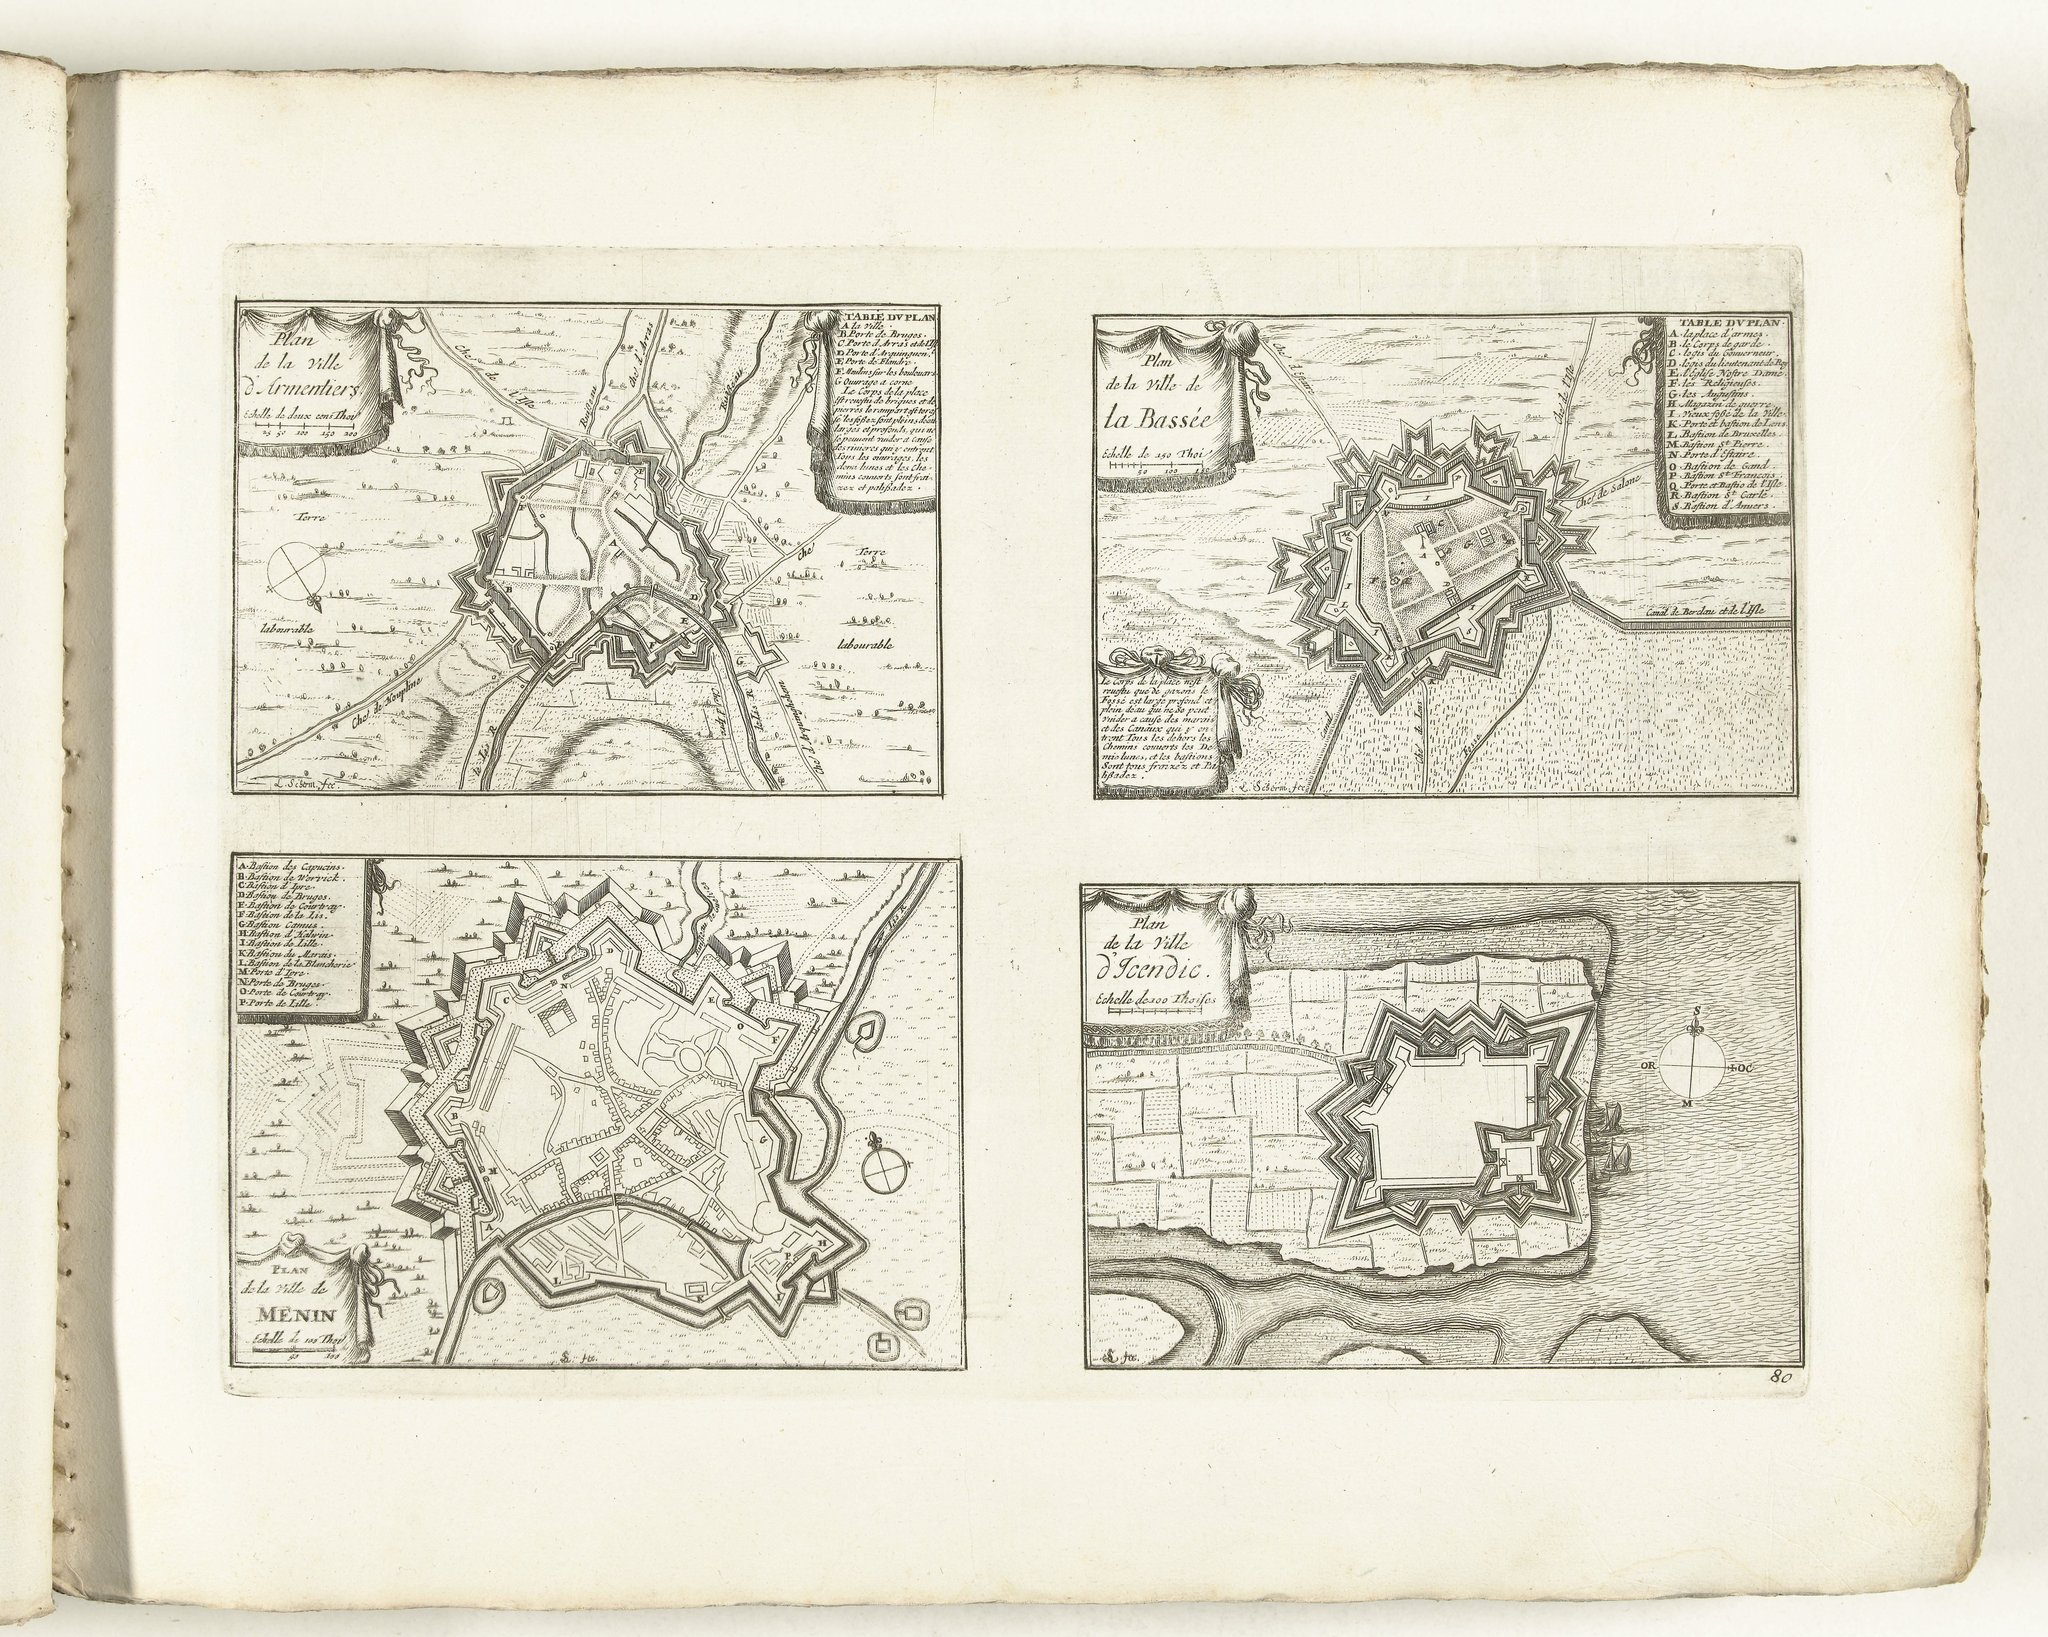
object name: map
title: Plattegronden van Armentieres, La Bassée, Menin en IJzendijke, ca. 1702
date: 1702-1703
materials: paper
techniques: engraving, etching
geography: amsterdam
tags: fortress, maps of cities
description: Blad met vier plattegronden van de versterkingen om de plaatsen Armentieres, La Bassée, Menin en IJzendijke. Plaat nr. 80 in het prentwerk bestaande in totaal uit 276 genummerde platen van vermaarde sterke steden en vestingen in het kader van de Spaanse Successieoorlog. Voor het merendeel zijn deze platen gekopieerd naar de anonieme Franse platen: in Les forces de l'Europe en in: Le theatre de la guerre, dans les Pays-Bas, beide oorspronkelijk uitgegeven door Nicolas de Fer te Parijs (1693-1697) in het kader van de Negenjarige Oorlog. Titel en opschriften in de plaat in het Frans.